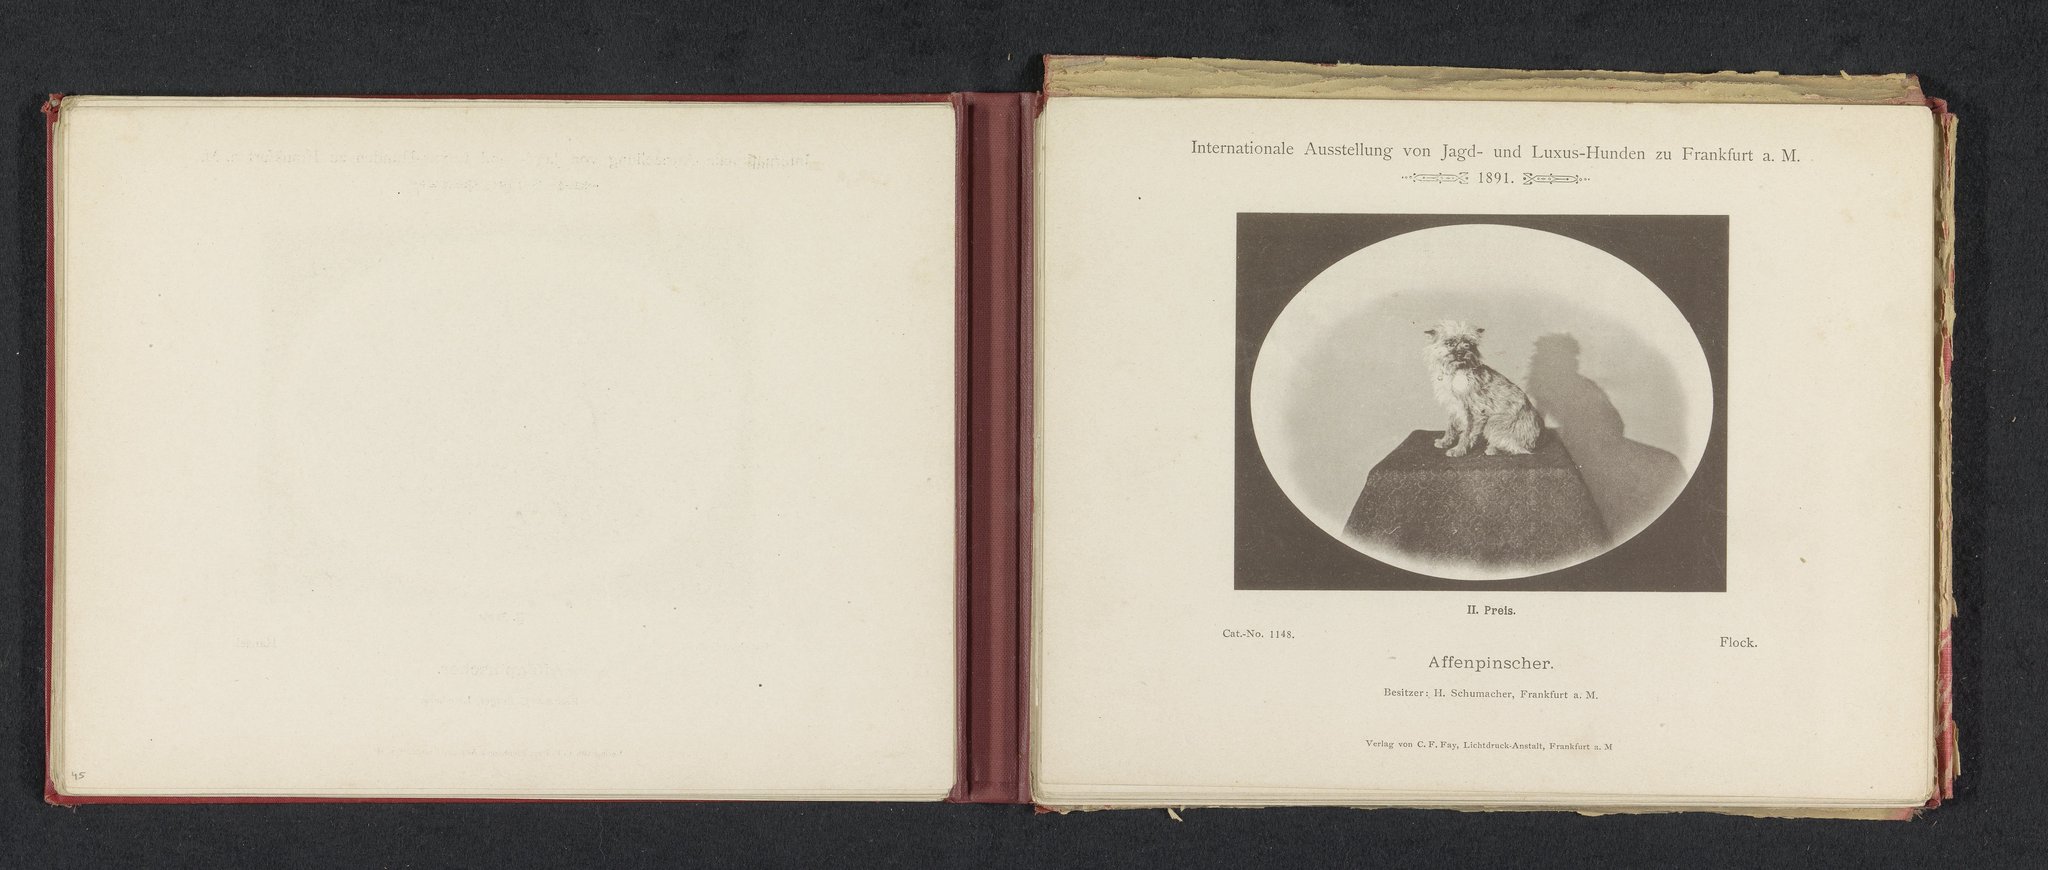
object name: page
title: Internationale Ausstellung von Jagd- und Luxus-Hunden zu Frankfurt a. M. 1891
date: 1891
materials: paper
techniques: photograph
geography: frankfurt am main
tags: dog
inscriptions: inscription: ‘II. Preis. Flock. Besitzer : H. Schumacher, Frankfurt a. M.’, number: ‘Cat.-No. 1148.’